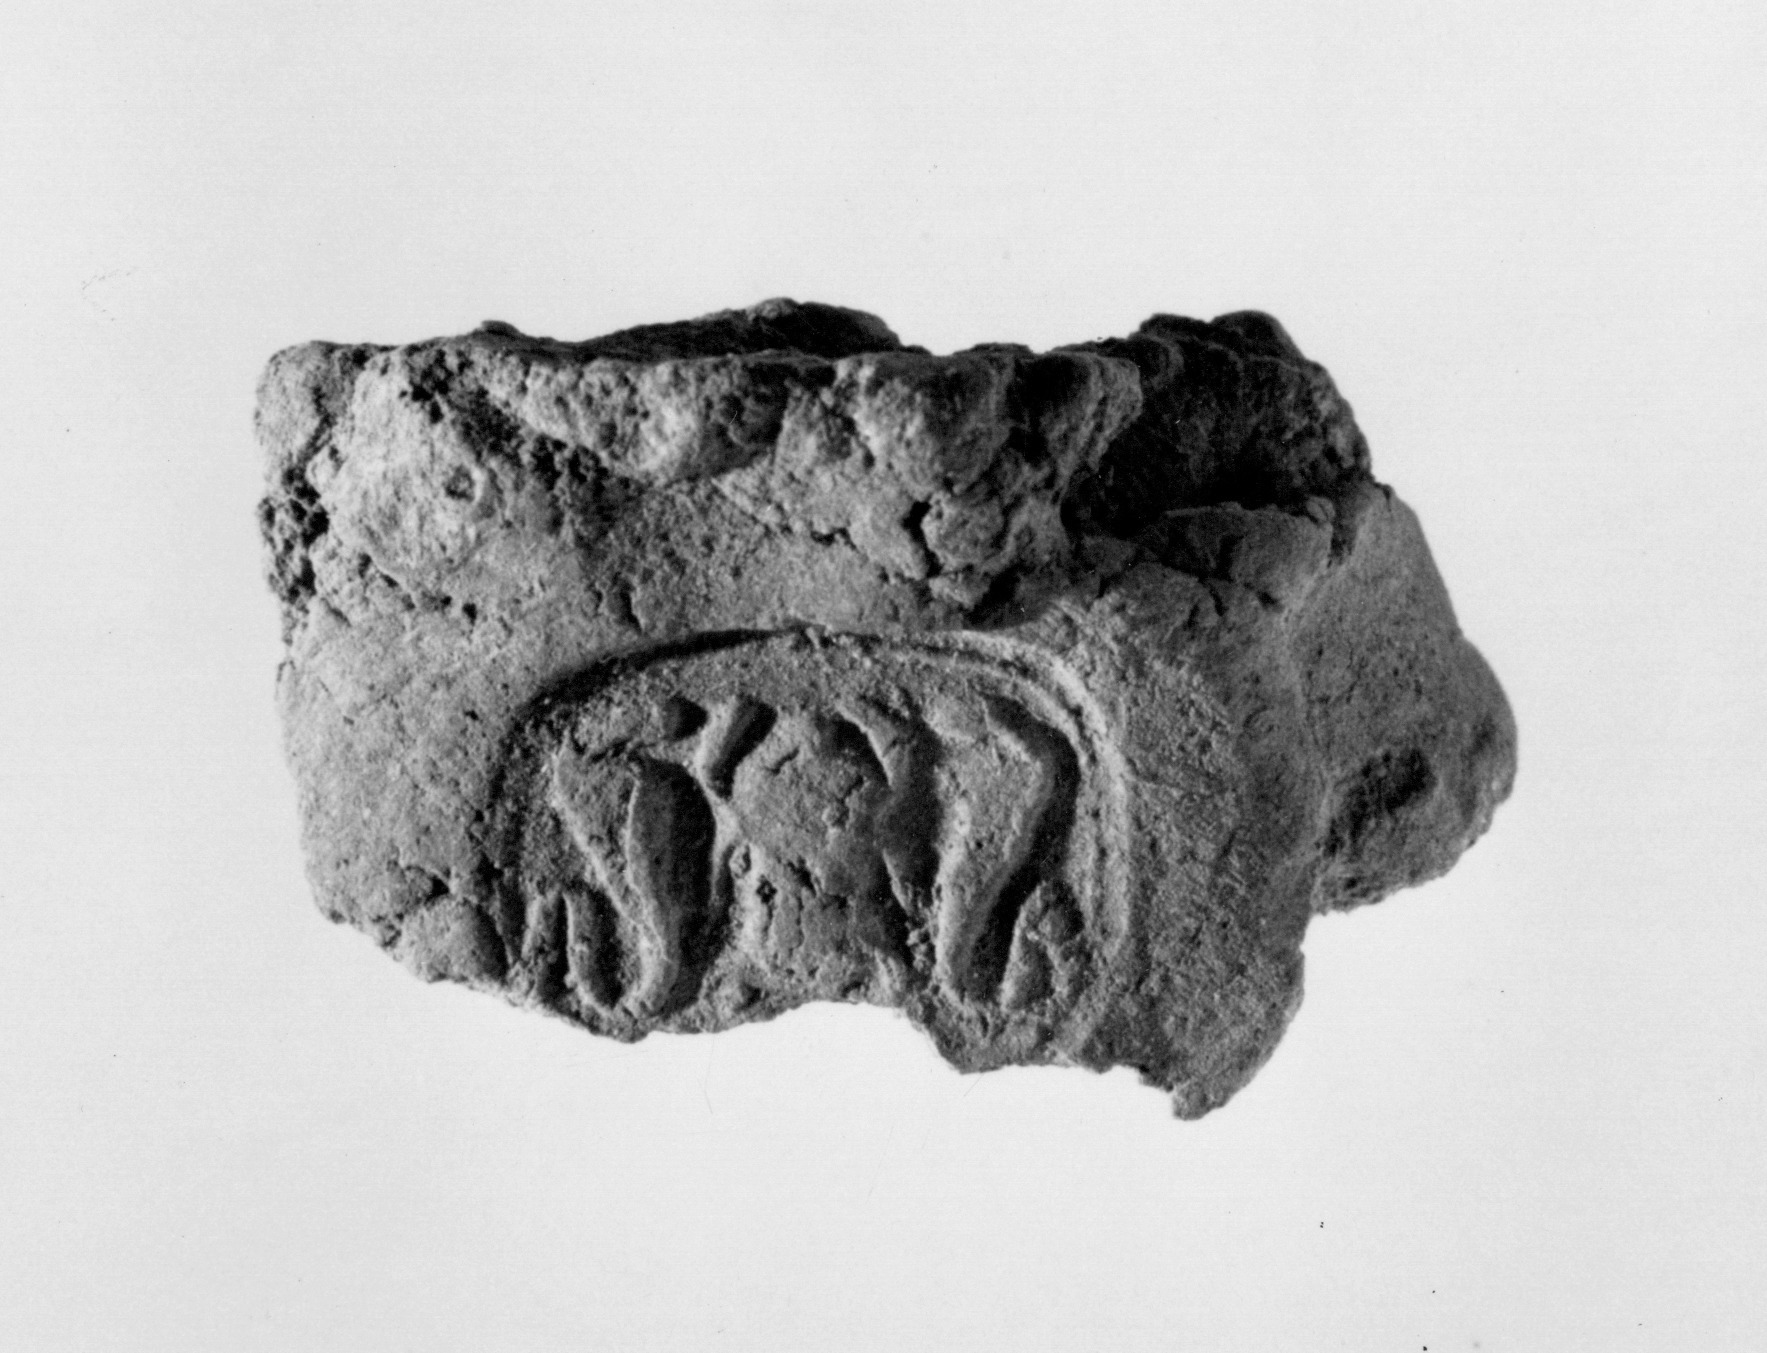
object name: sealing, cobra, scarab, uraeus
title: Document Sealing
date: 1390-1352 BCE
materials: mud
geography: egypt